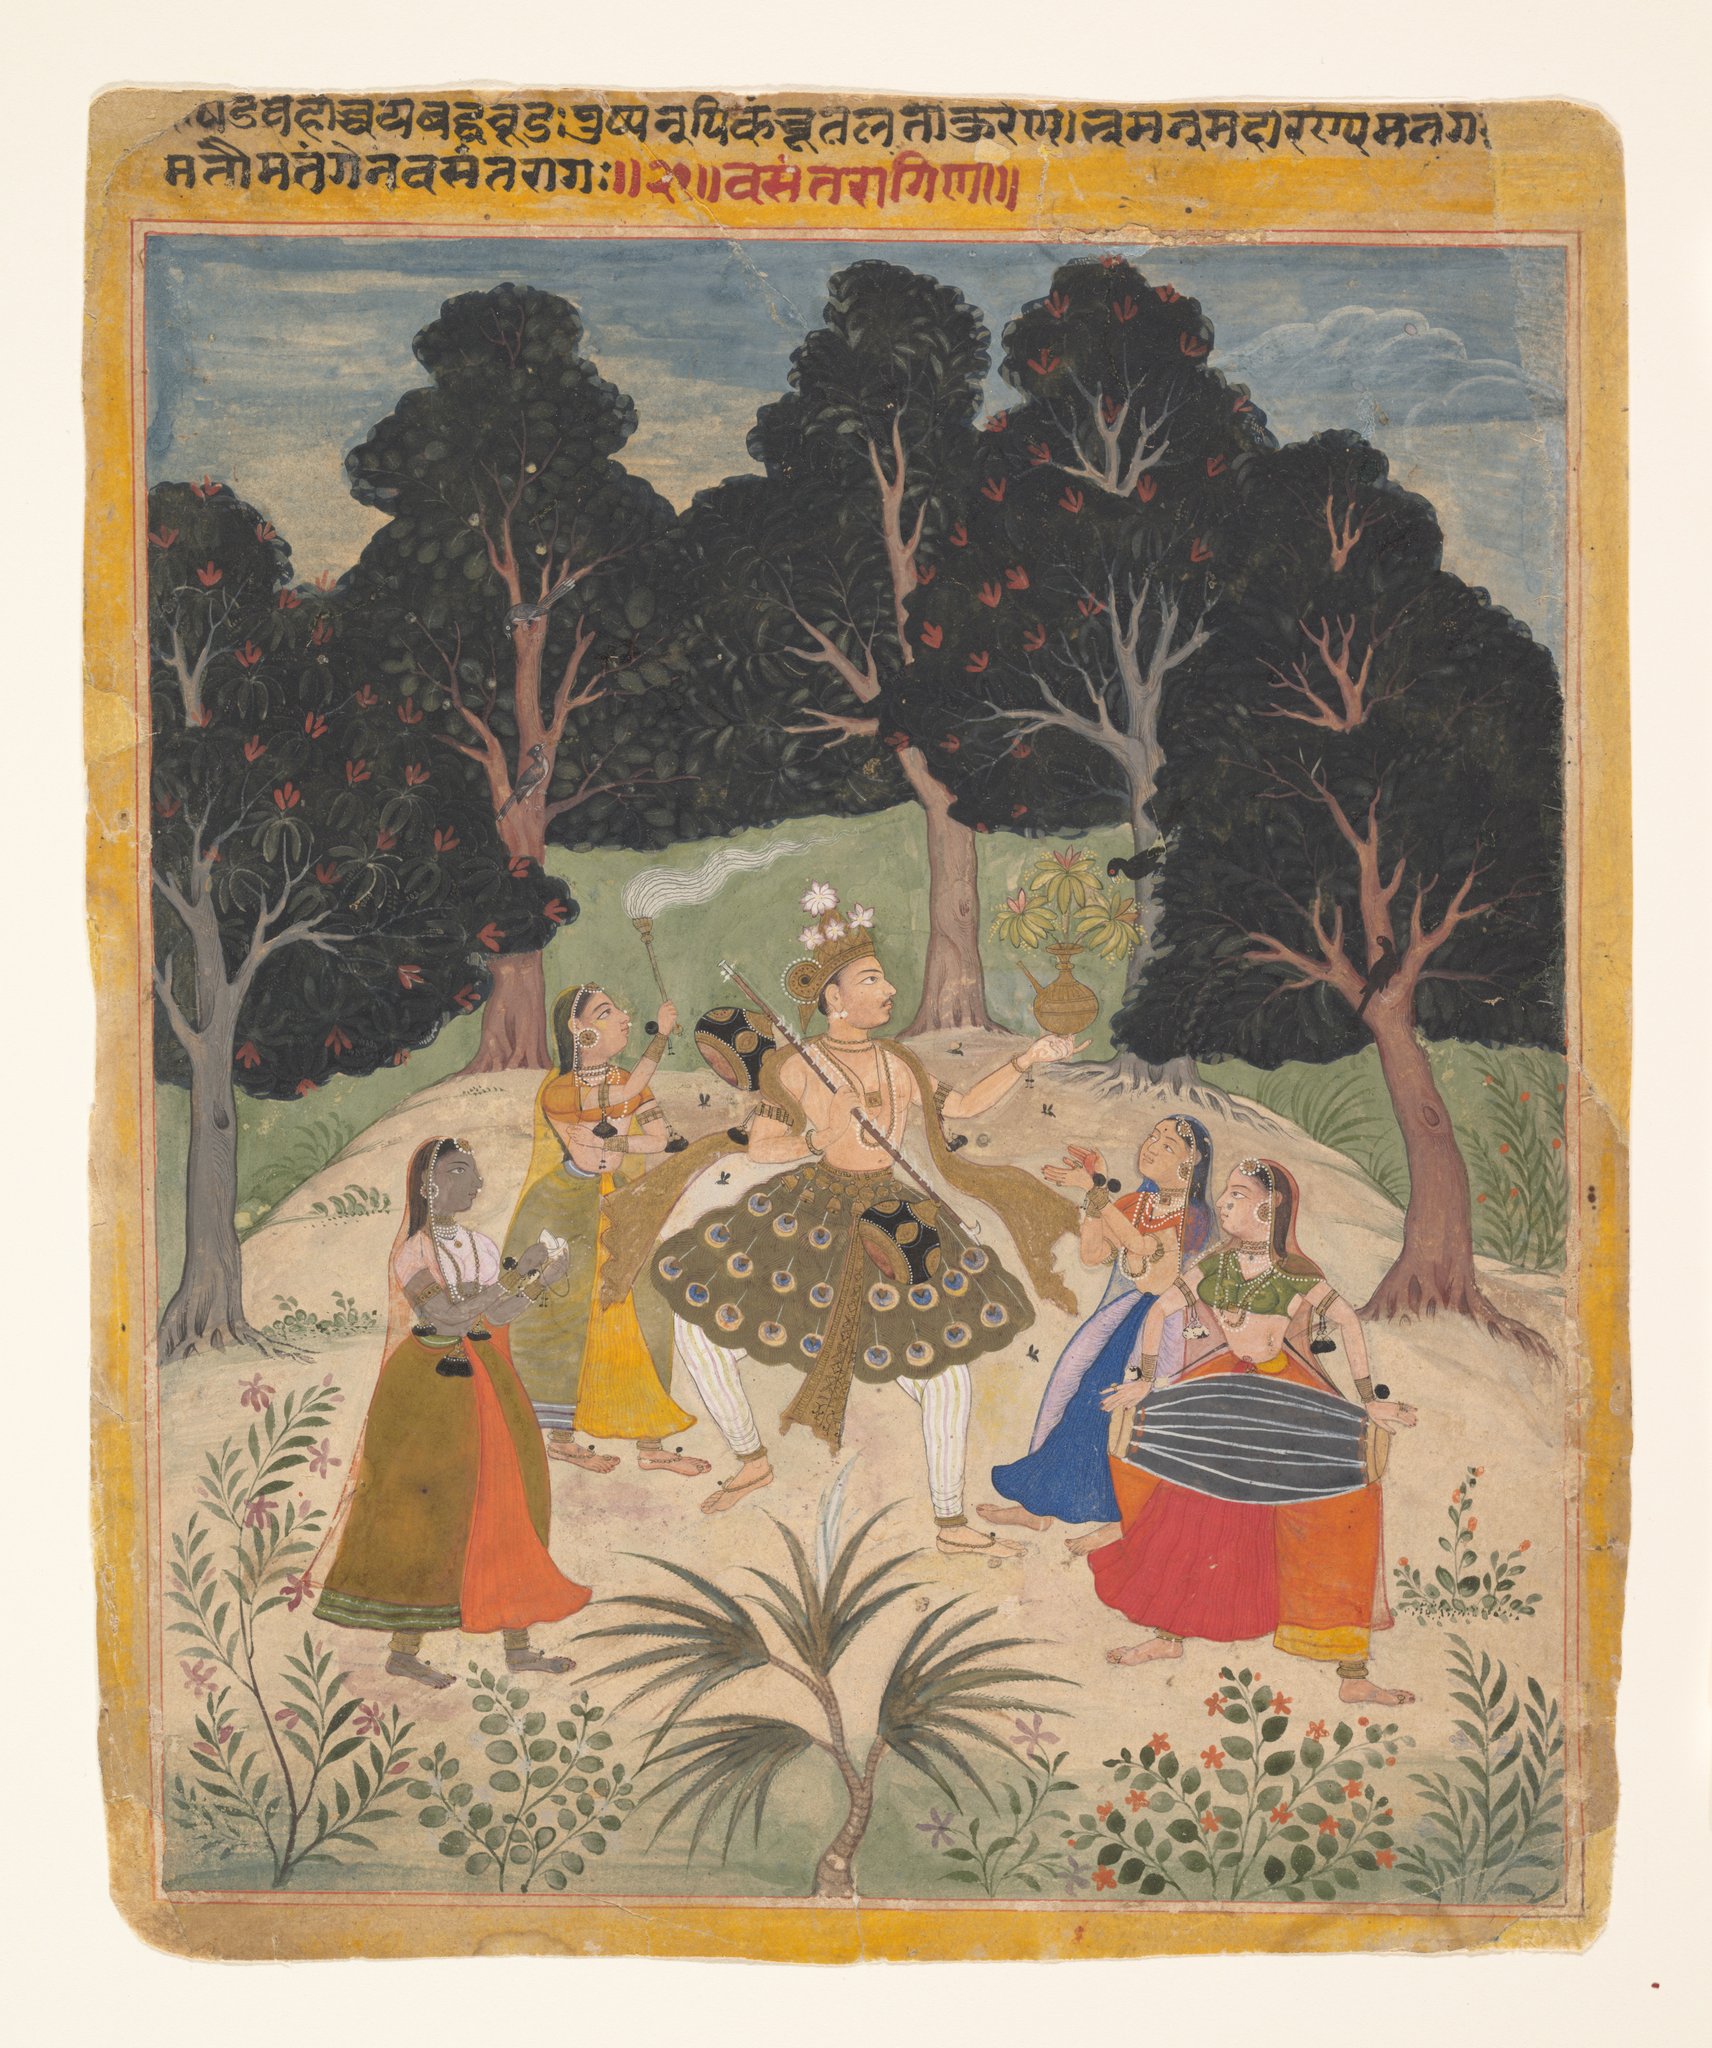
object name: page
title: Vasant Ragini, Page from a Ragamala Series (Garland of Musical Modes)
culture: indian or rajasthan or amber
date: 1601-1633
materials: gold, ink, paper, watercolor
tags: musical instruments,men,women,dancing